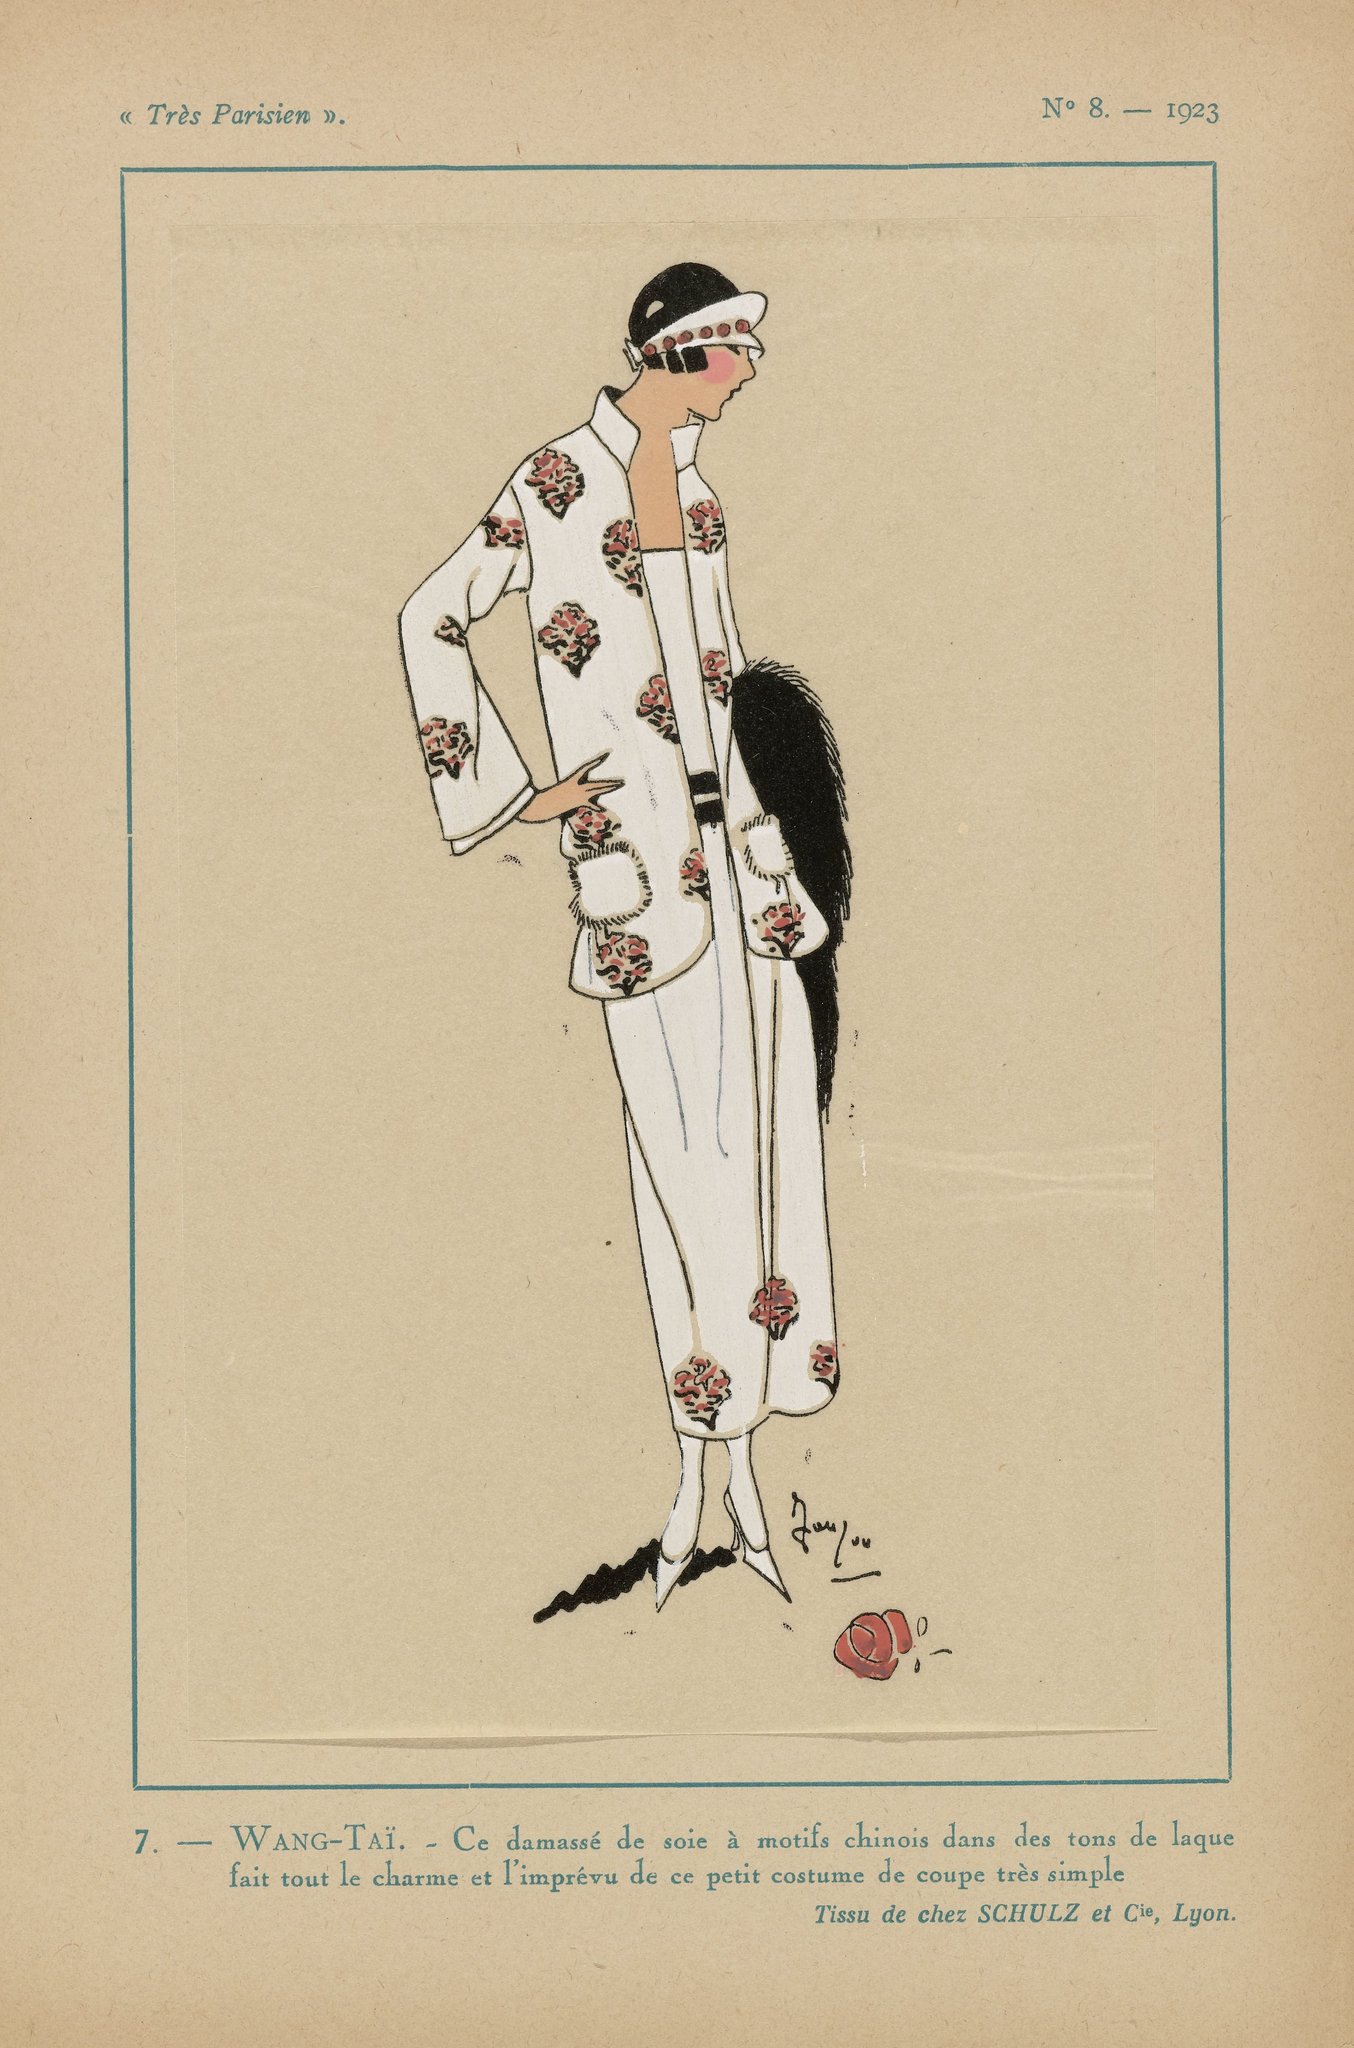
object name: fashion print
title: Très Parisien, 1923, No 8: 7.- WANG-TAÏ. - Ce damassé de soie...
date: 1923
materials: paper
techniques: hand coloring, letterpress printing, lithography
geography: lyon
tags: diadem, tiara (+ women's clothes), ensembles of pieces of clothing (suit) (+ women's clothes), coat (+ women's clothes), fashion plates, skirt (+ women's clothes)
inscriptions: caption: ‘7. - WANG-TAÏ. - Ce damassé de soie à motifs chinois dans des tons de laque fait tout le charme et l'imprévu de ce petit costume de coupe très simple. / Tissu de chez SCHULZ et Cie, Lyon.’, title: ‘Très Parisien / No 8. - 1923’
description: Kostuum (mantelpak) van 'damassé de soie' met chinese motieven in dezelfde tinten als lakwerk. Stof van Schulz et Cie. Prent uit het modetijdschrift Très Parisien (1920-1936).